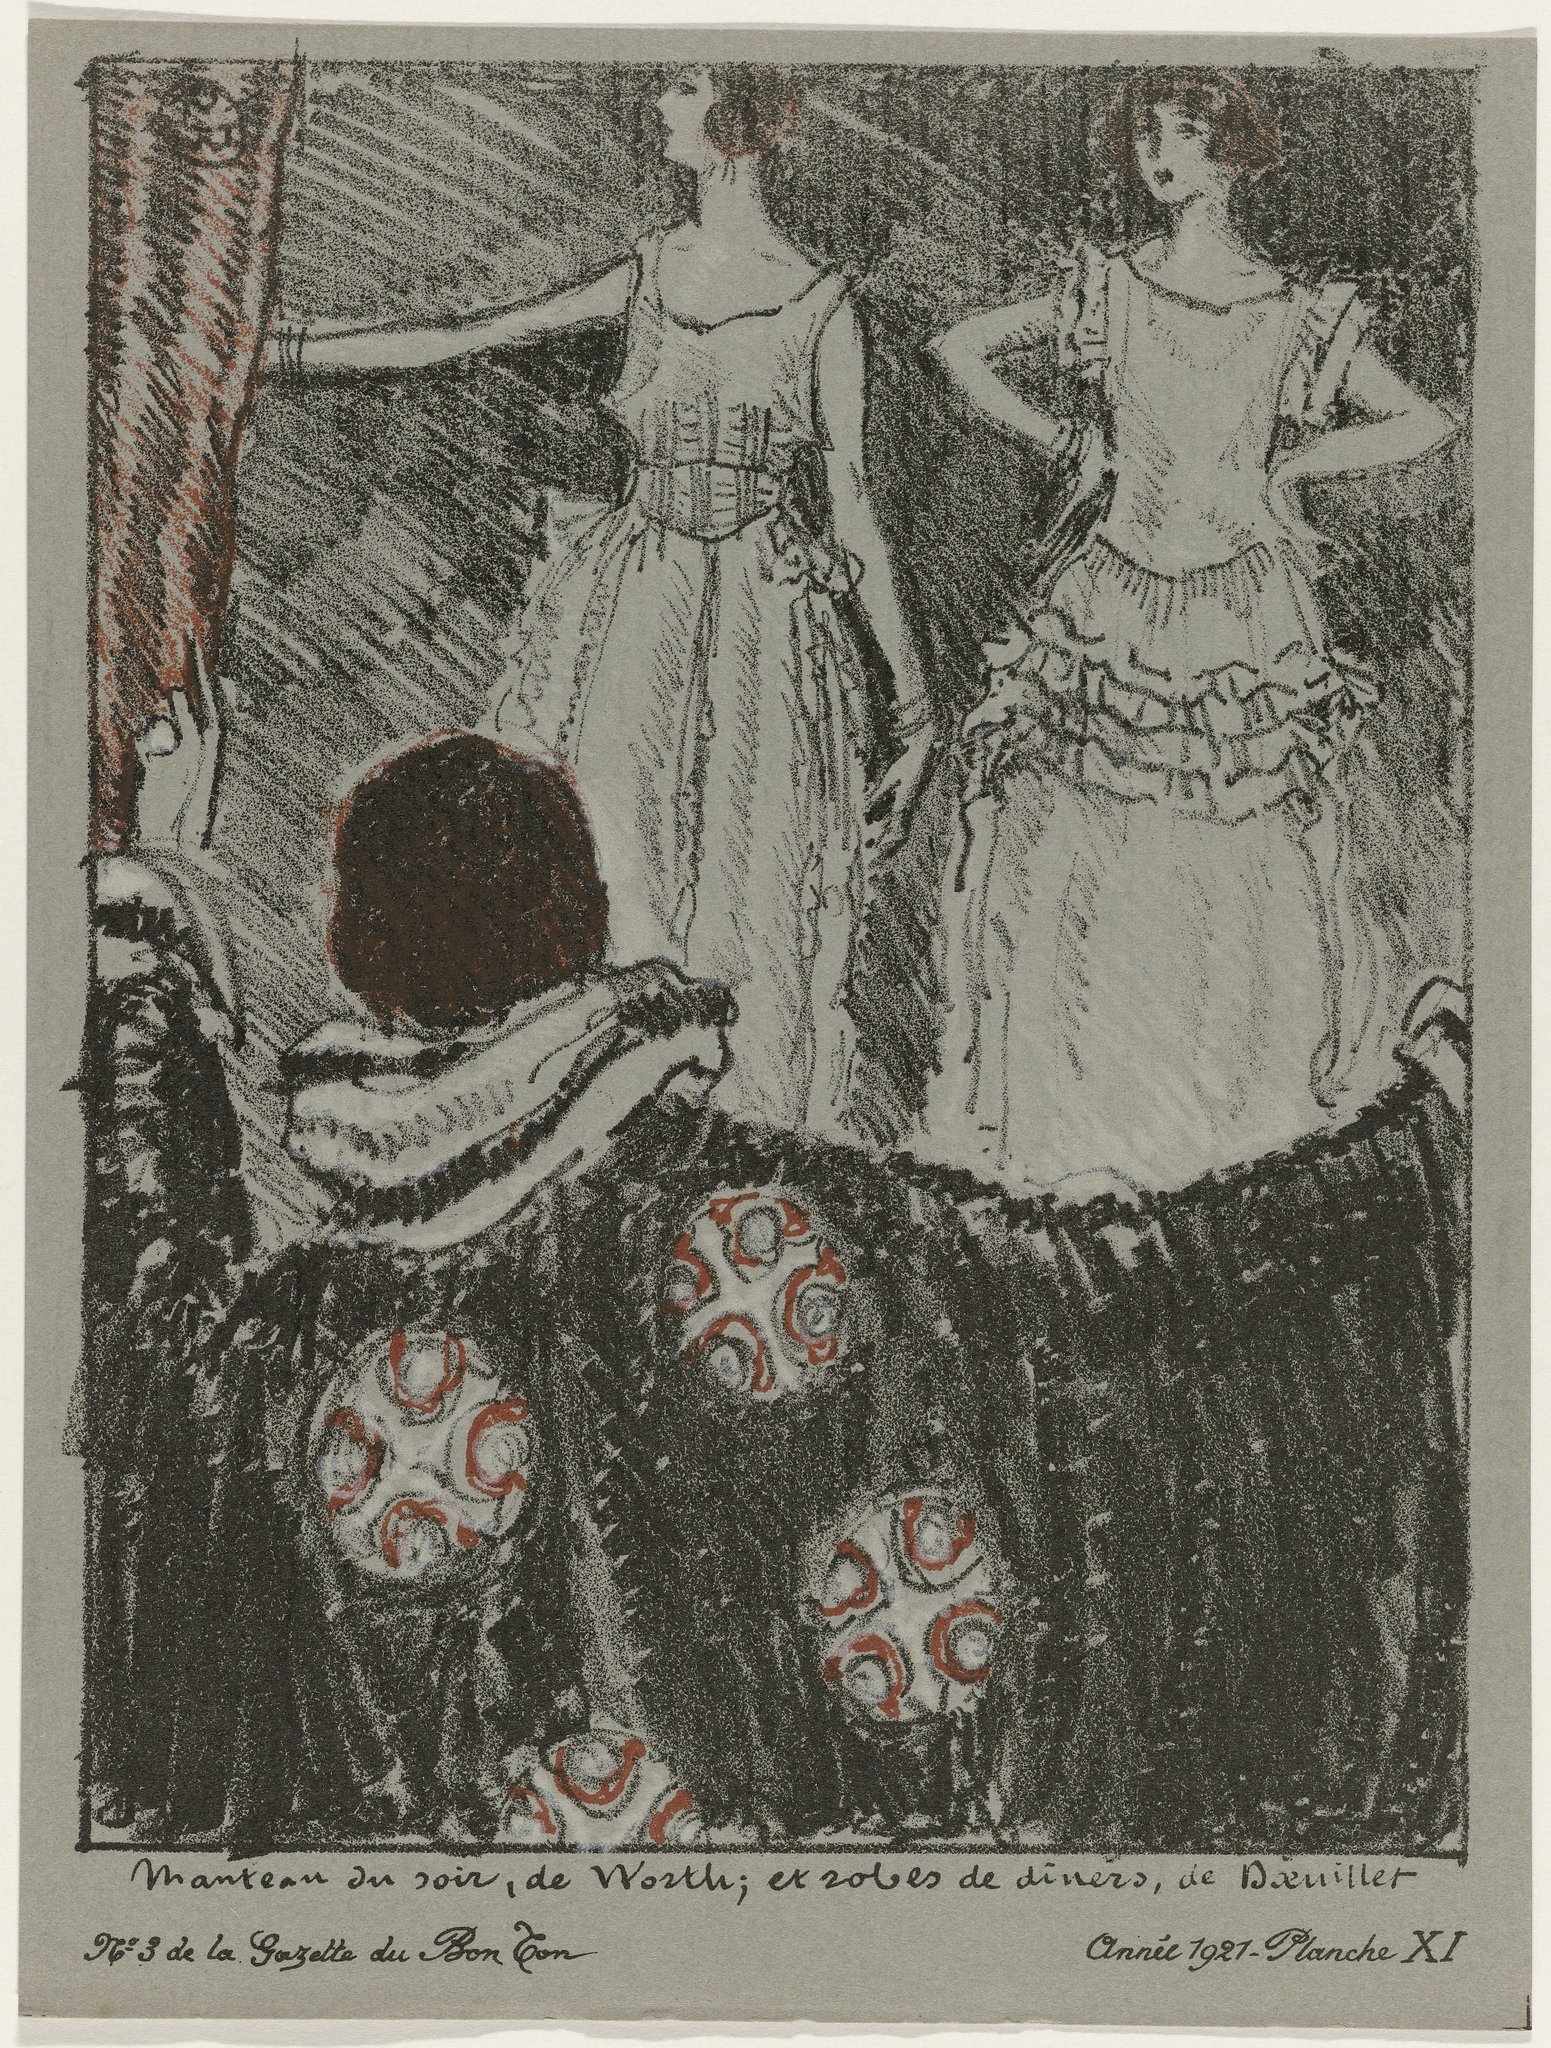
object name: fashion print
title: Gazette du Bon Ton, 1921 - No. 3, Pl. XI: Manteau du soir, de Worth; et robes de dîners, de Doeuillet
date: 1921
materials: paper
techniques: lithograph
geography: paris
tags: dress, gown: dinner dress (+ women's clothes), coat (evening coat) (+ women's clothes), fashion plates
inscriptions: date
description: De vrouw op de voorgrond, op de rug gezien, is gekleed in een zwarte avondmantel van Worth. De andere twee vrouwen dragen dinerjaponnen van Doeuillet. Planche XI uit een serie van vier litho's getiteld: 'Les modes en l'an de grace mil neuf cent vingt un', uit Gazette du Bon Ton 1921, No. 3. Uitleg over de kleding op pagina "Explication des Planches".